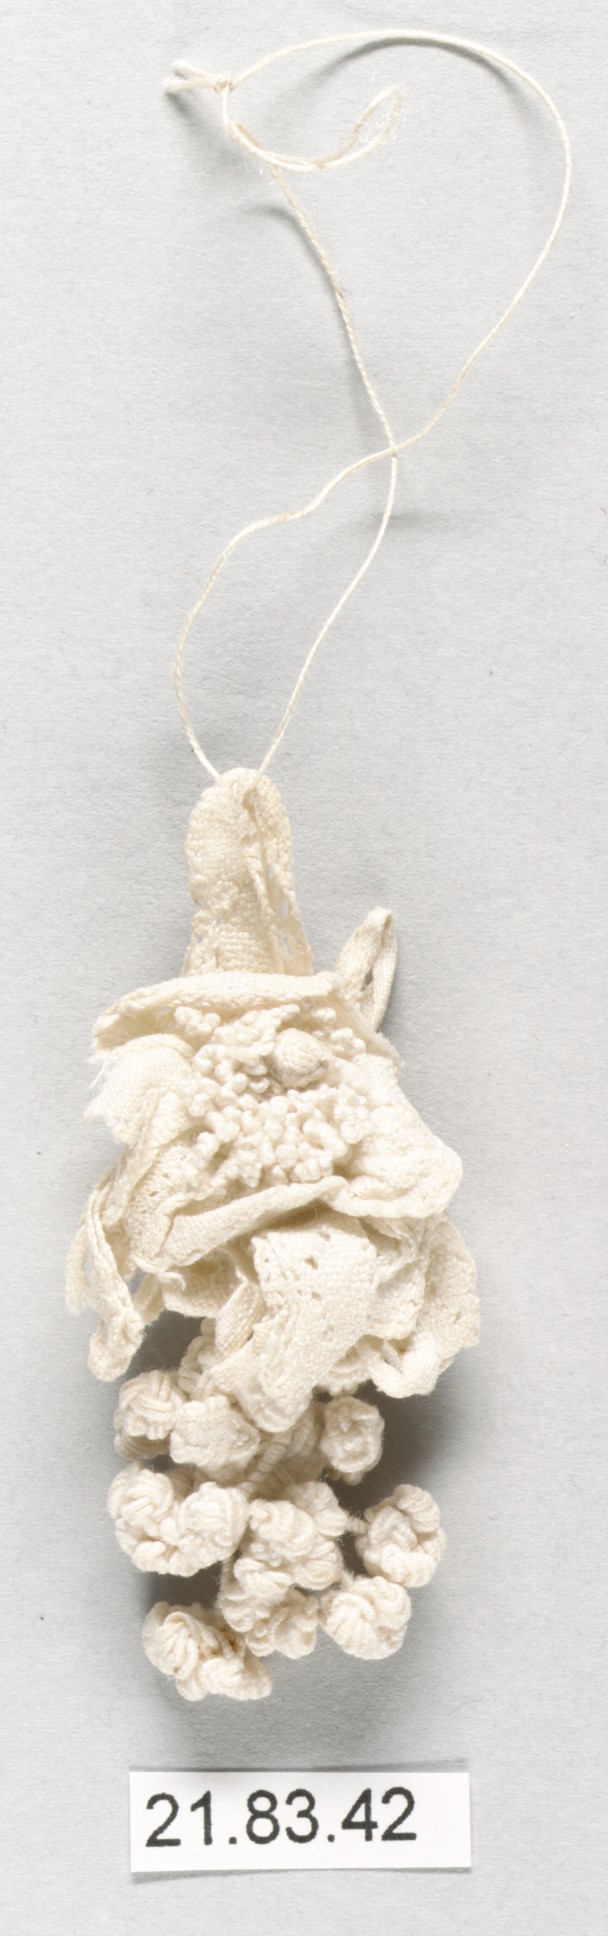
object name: tassel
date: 1601-1700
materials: linen